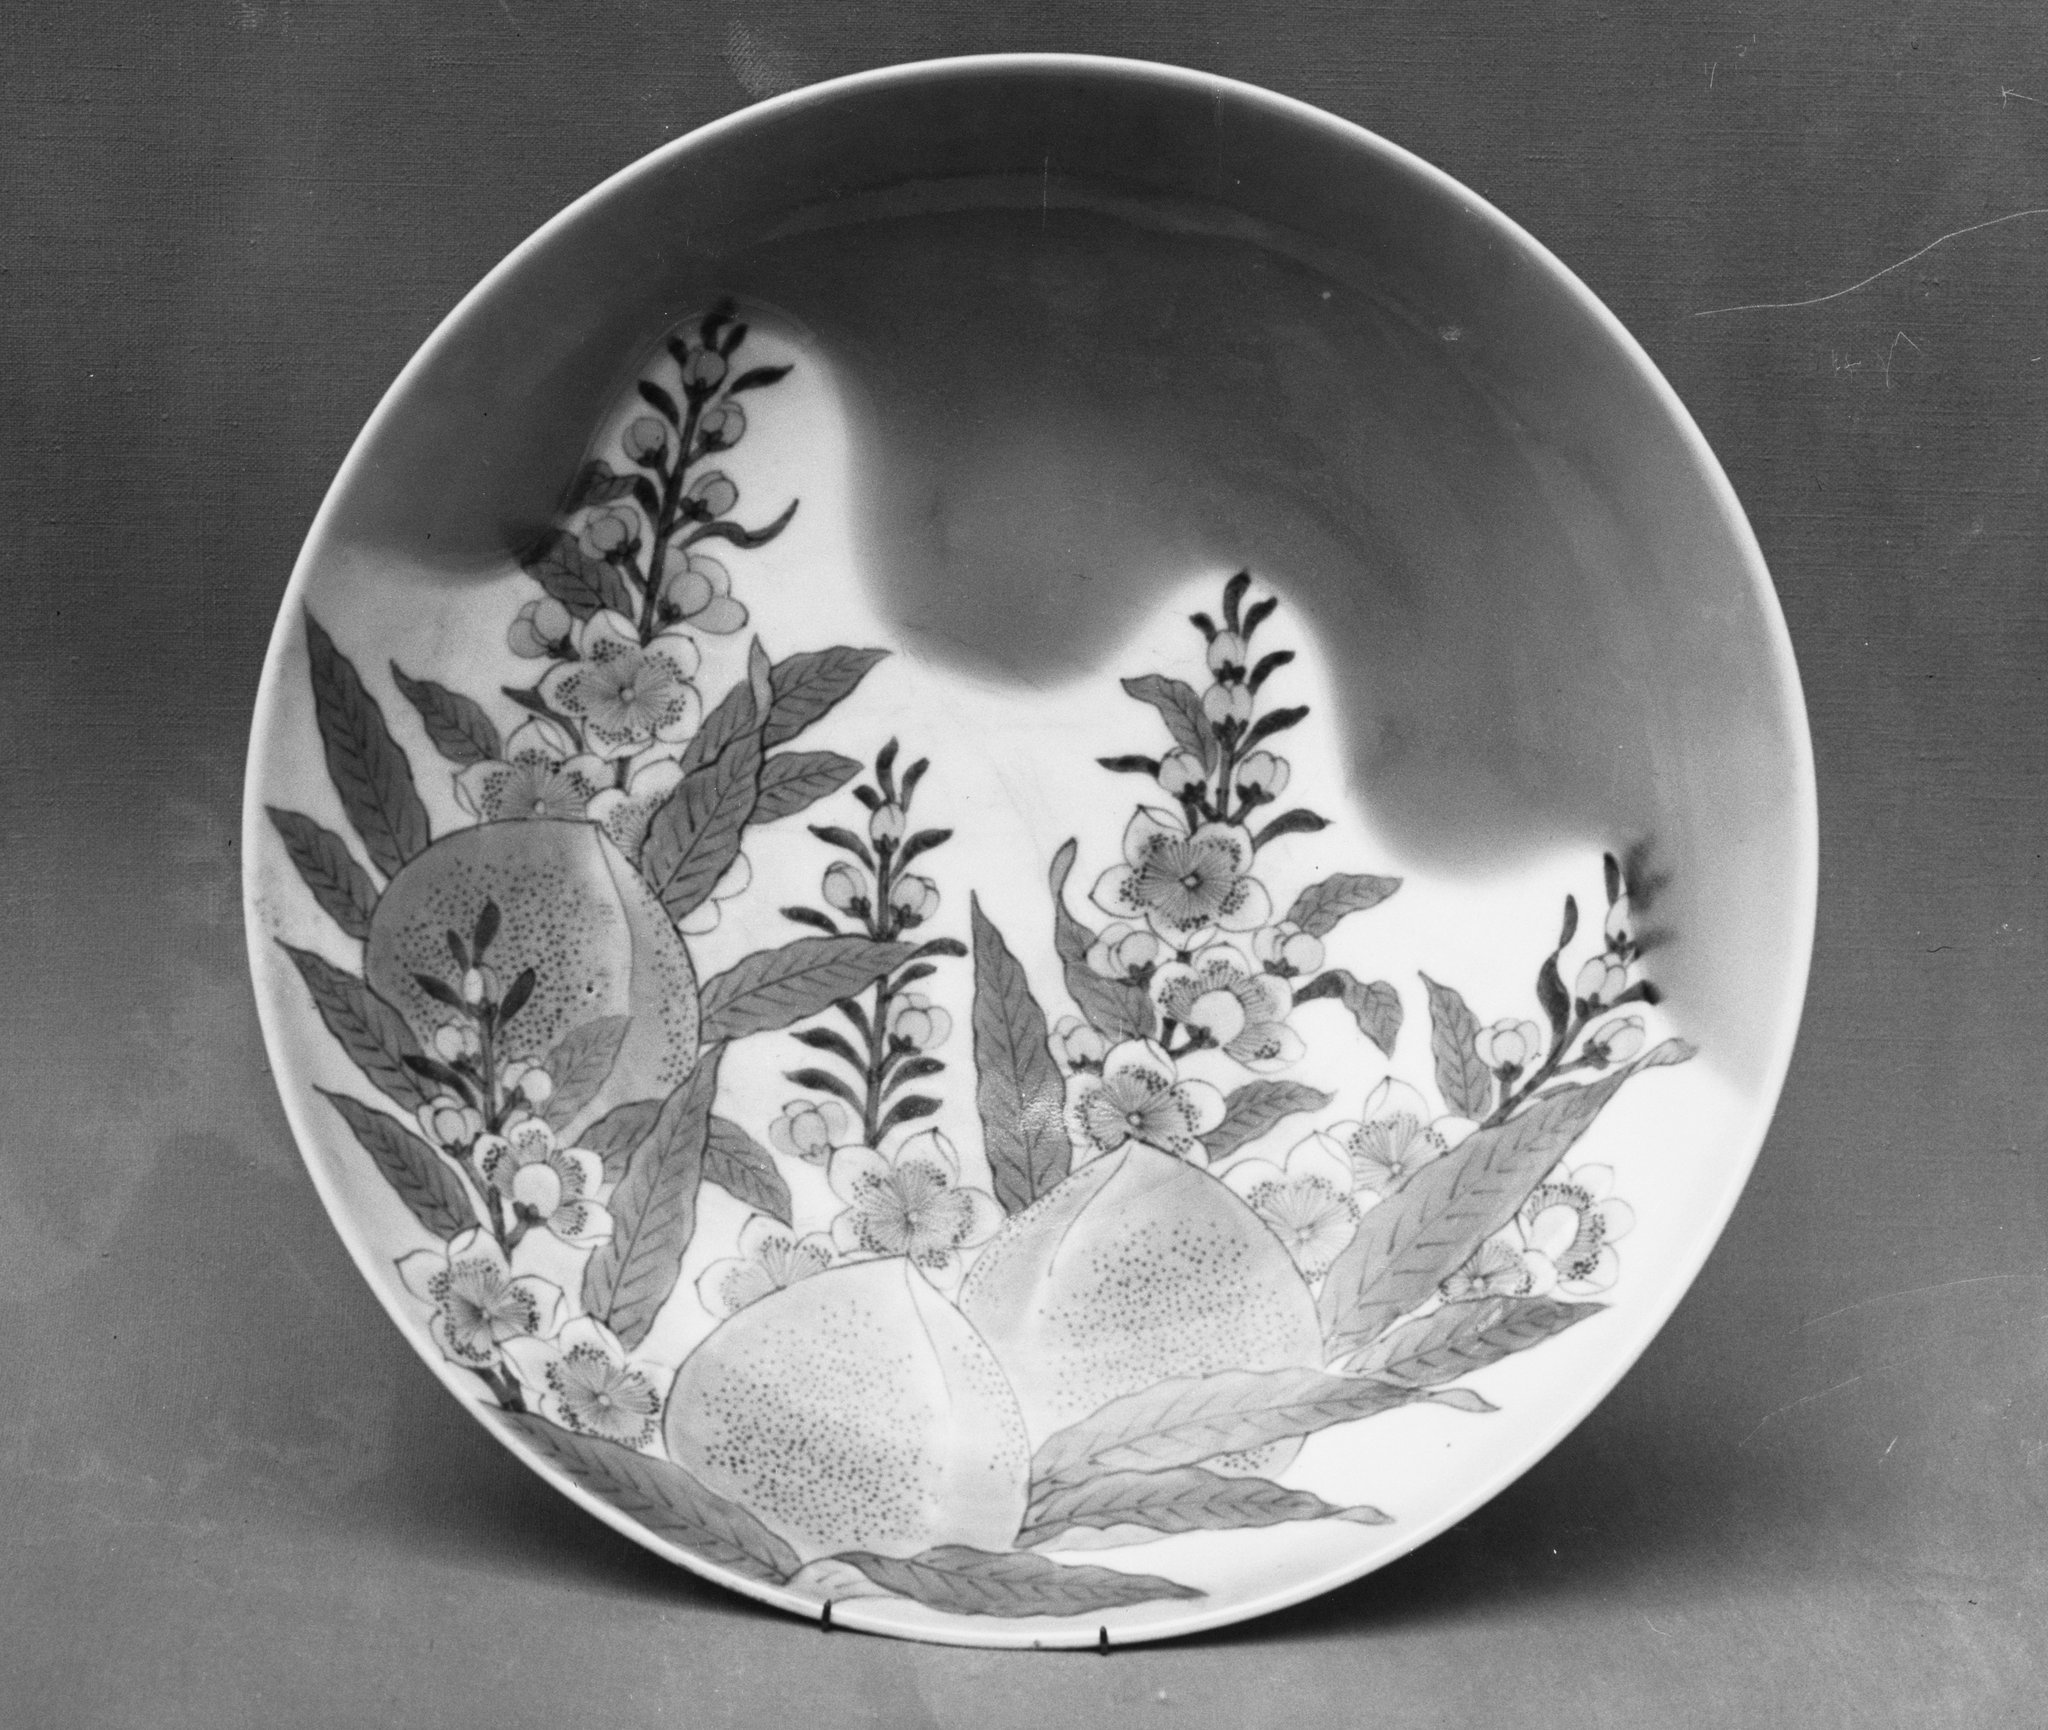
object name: dish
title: Dish with Peaches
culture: japanese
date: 1701-1800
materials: ceramic glaze, glaze, porcelain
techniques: underglaze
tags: peaches,flowers